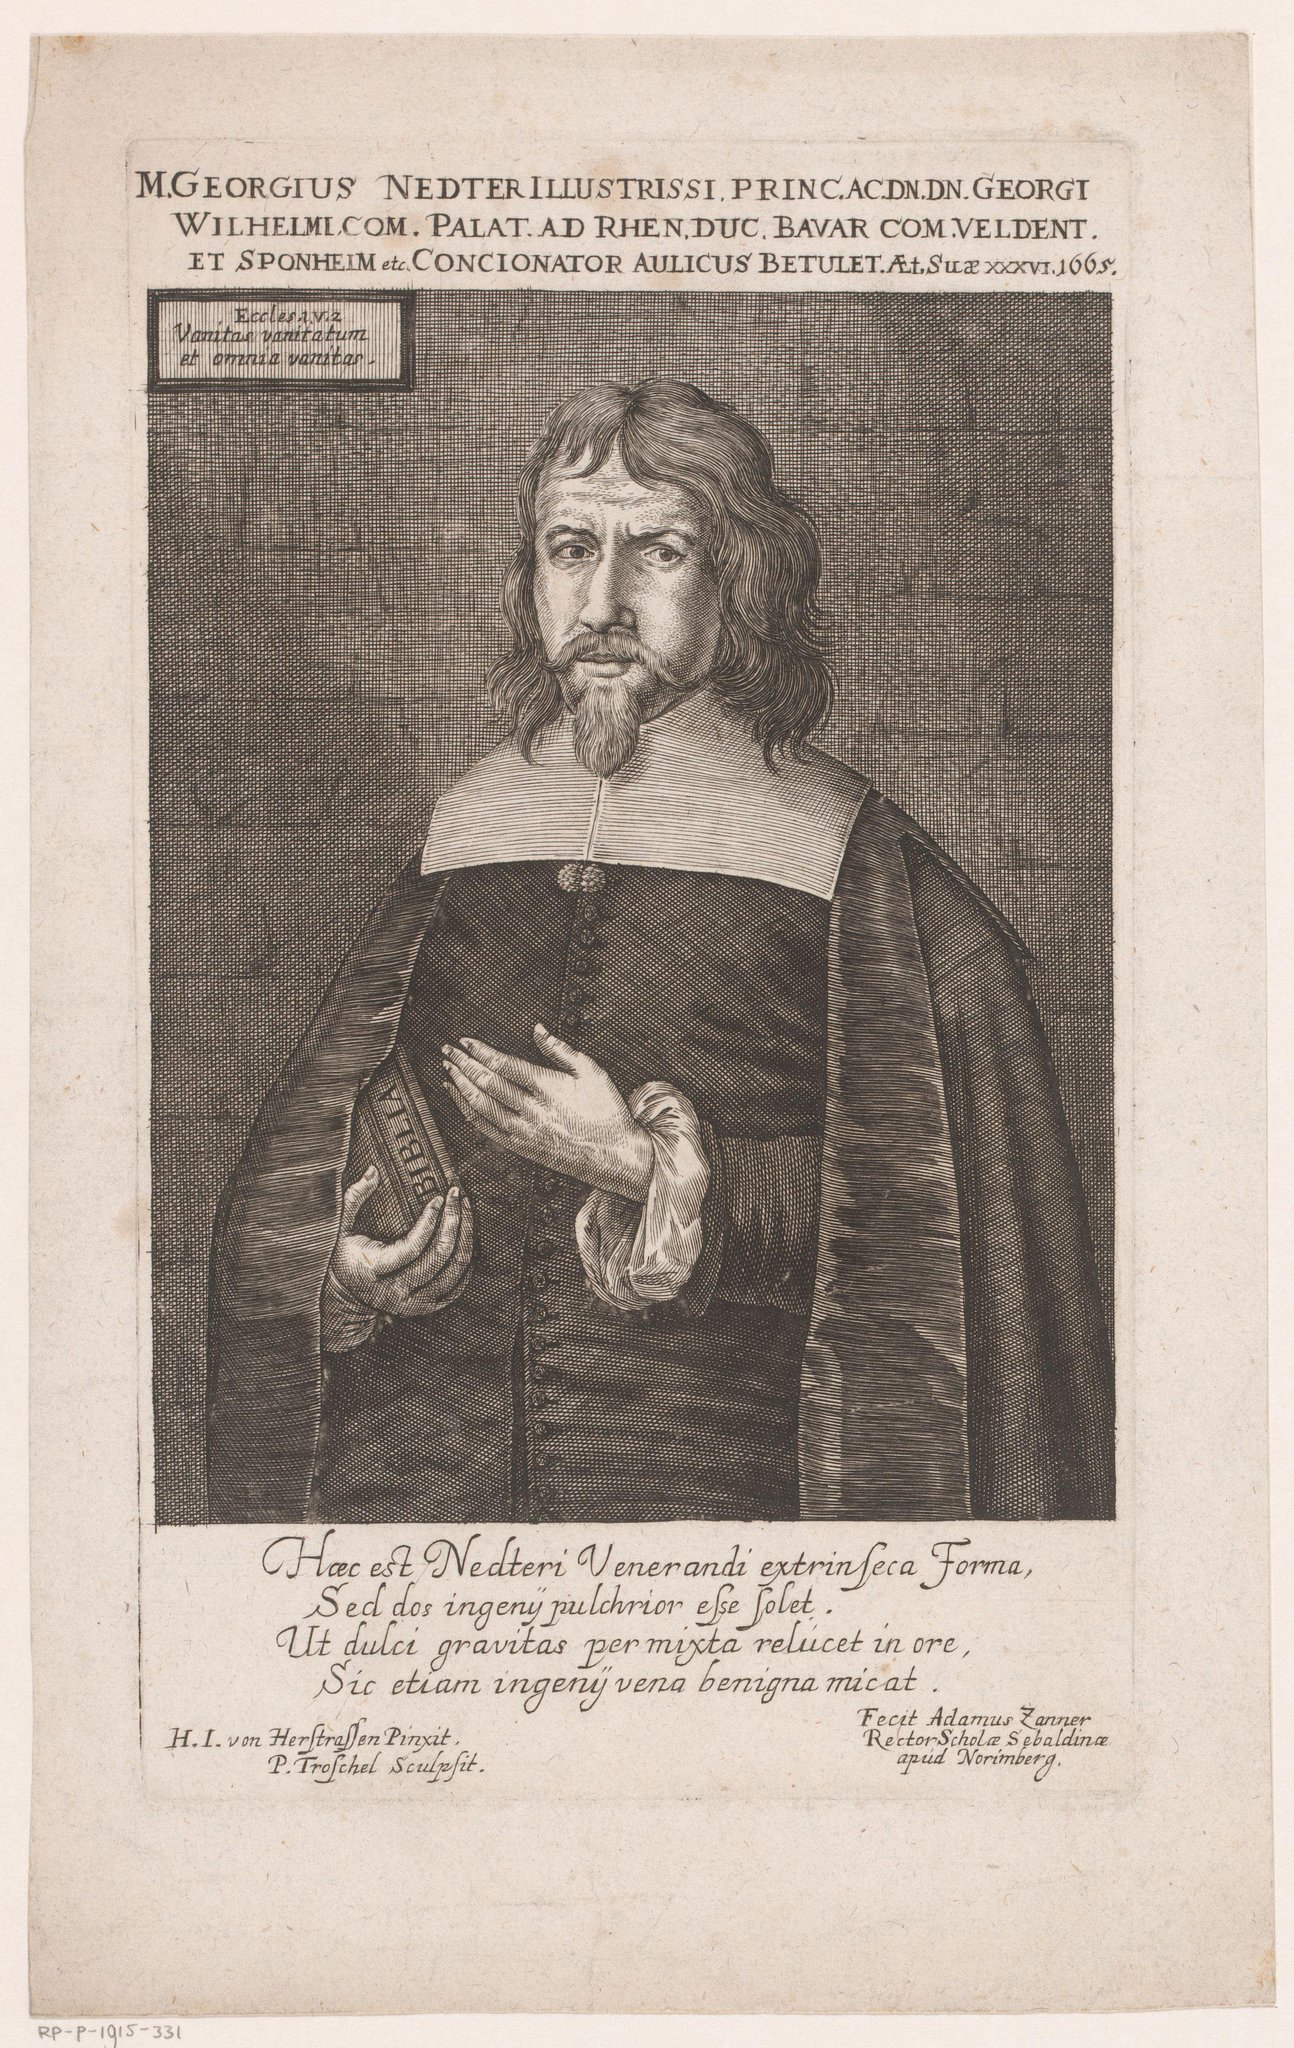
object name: print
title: Portret van Georg Nedter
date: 1665-1670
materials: paper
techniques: engraving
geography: germany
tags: historical persons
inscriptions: collector's mark: Lugt 2228